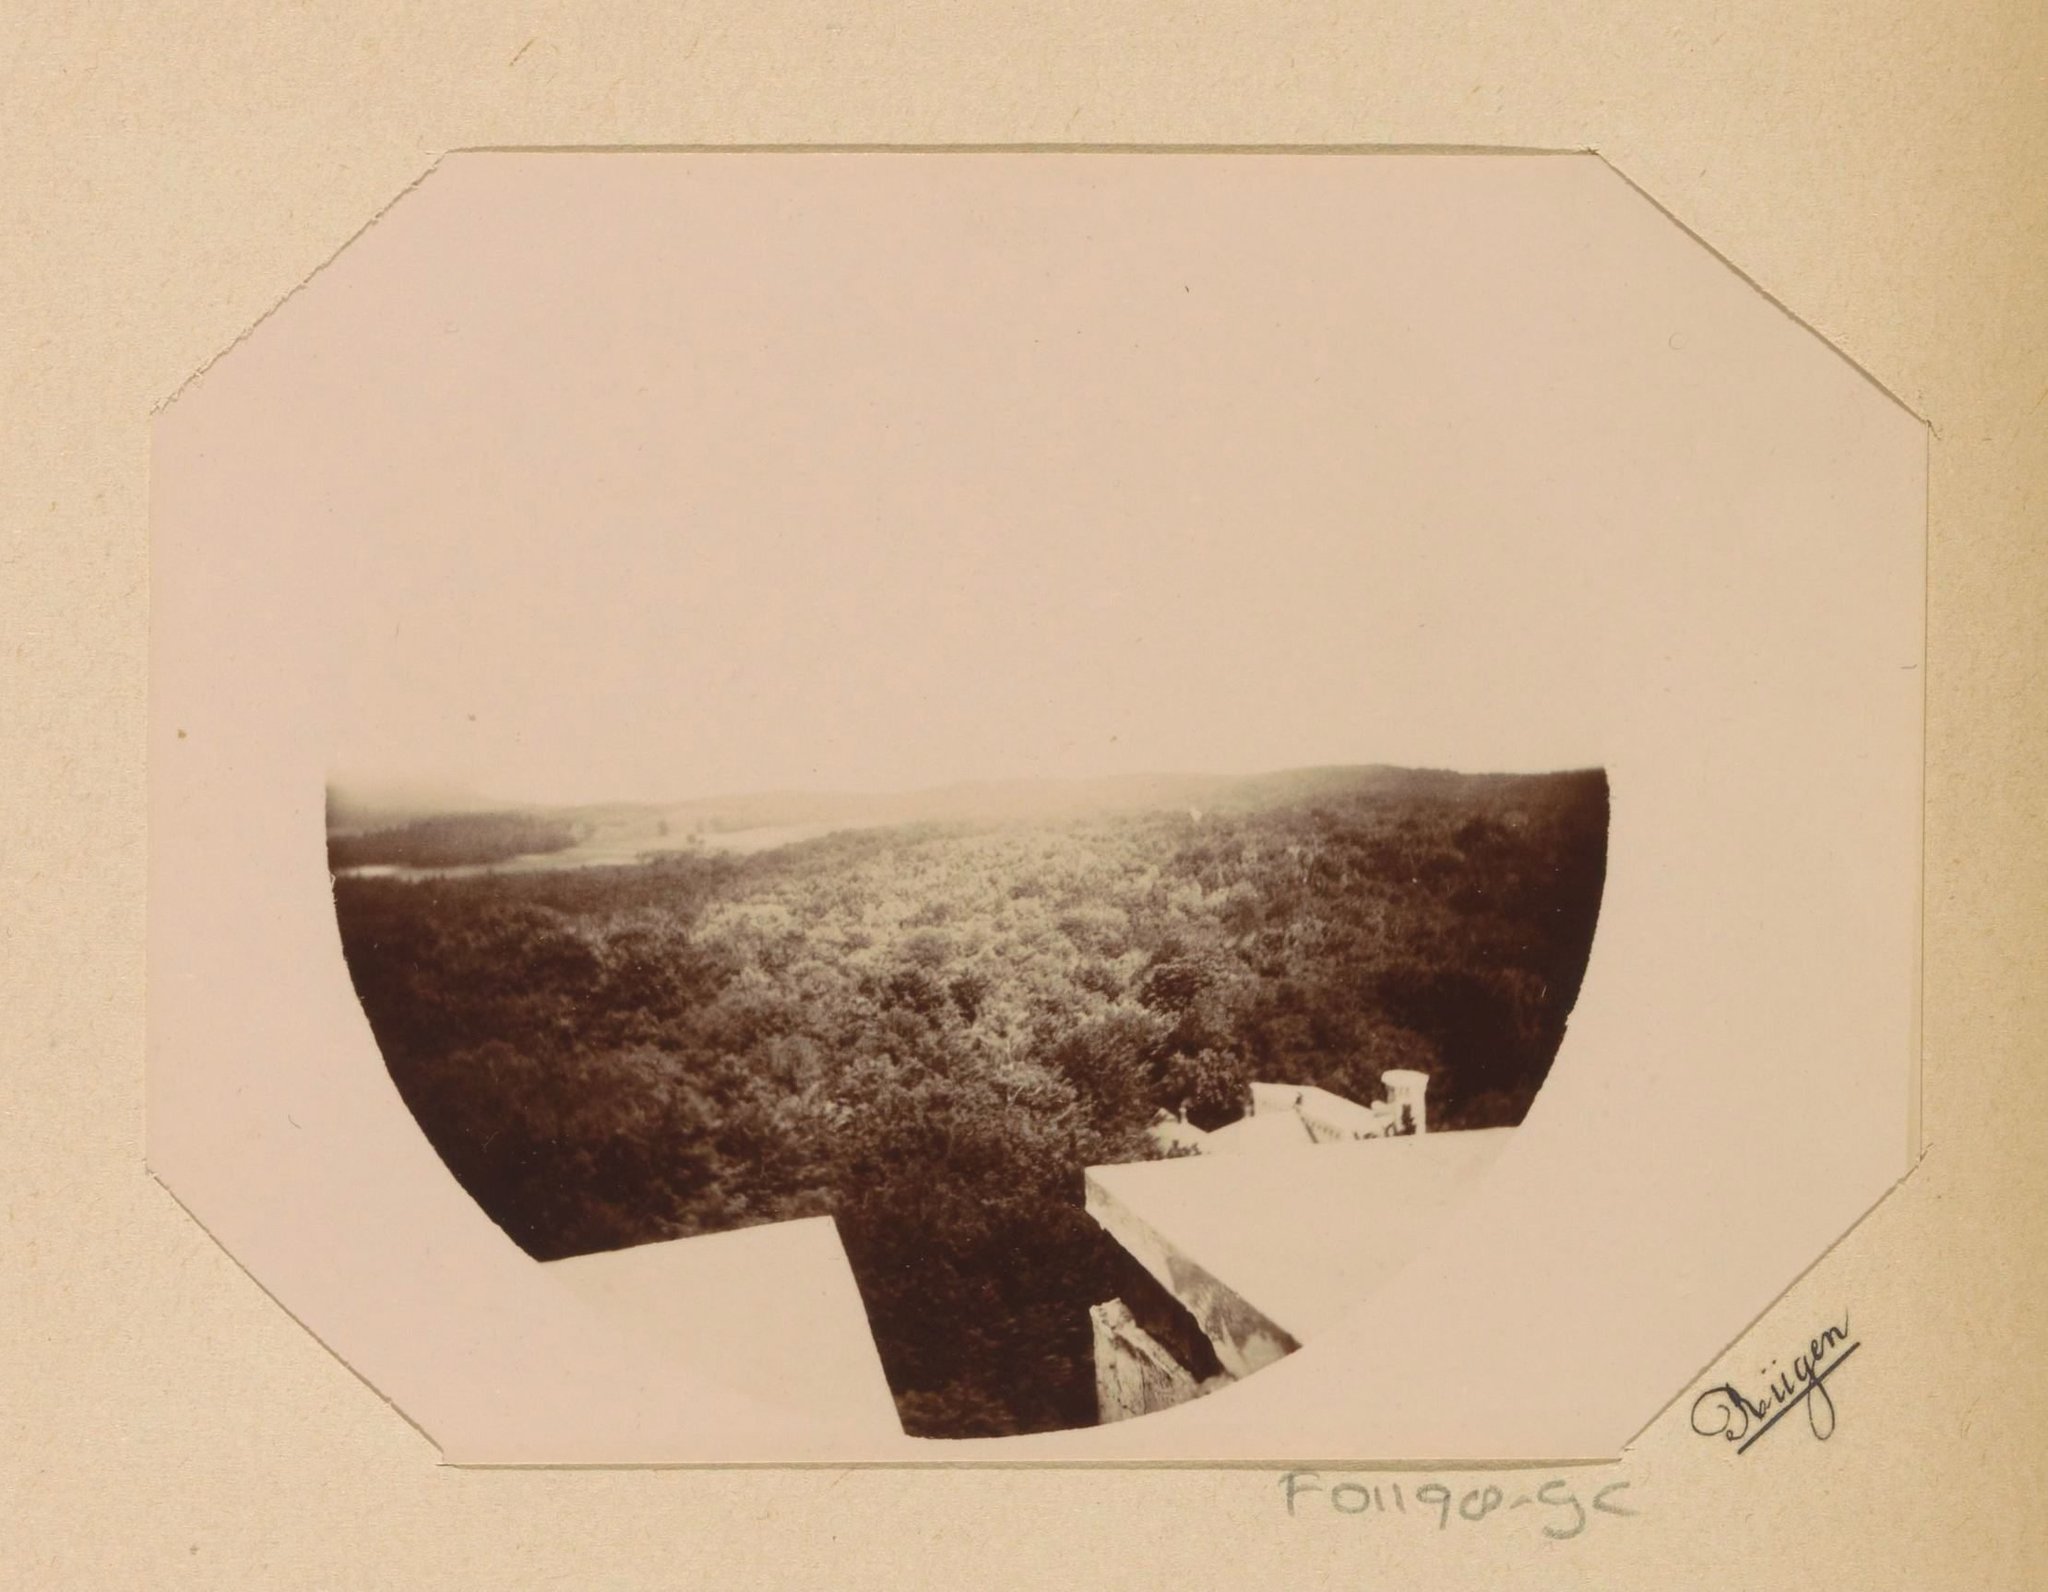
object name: photograph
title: Gezicht op Rügen in de Oostzee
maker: willem frederik piek jr.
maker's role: fotograaf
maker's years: 1874-1954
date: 1889-1893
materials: paper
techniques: gelatin silver print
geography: rügen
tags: island